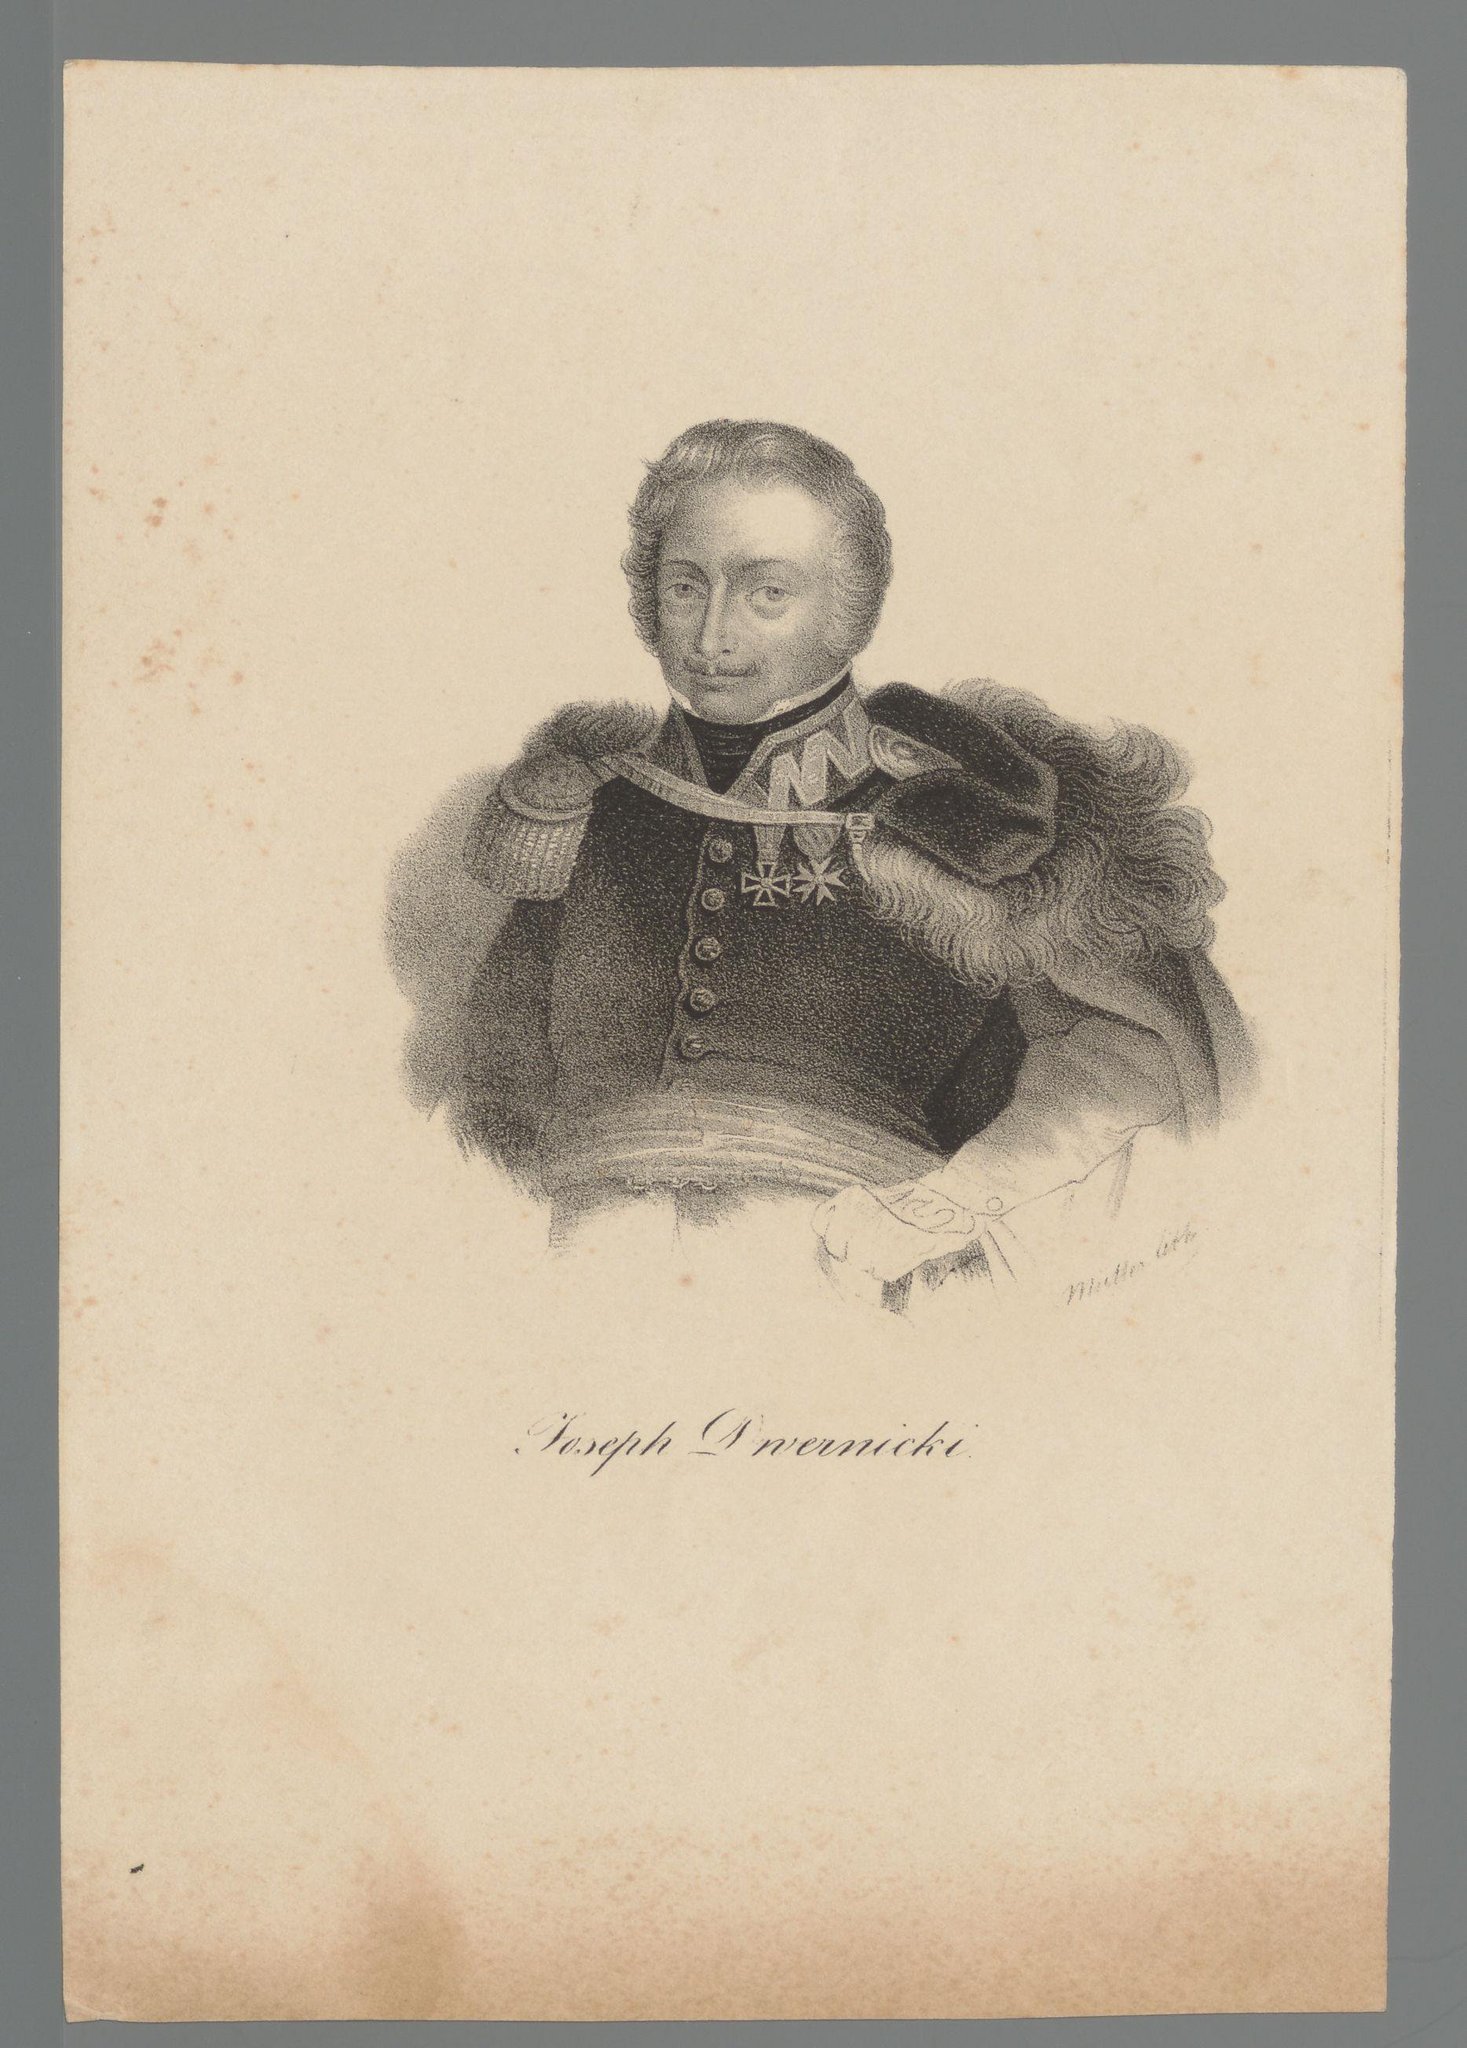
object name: print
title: Portret van Józef Dwernicki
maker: müller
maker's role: print maker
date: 1820-1850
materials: paper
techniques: lithograph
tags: adult man, historical persons, (military) uniforms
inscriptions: collector's mark: Lugt 2228